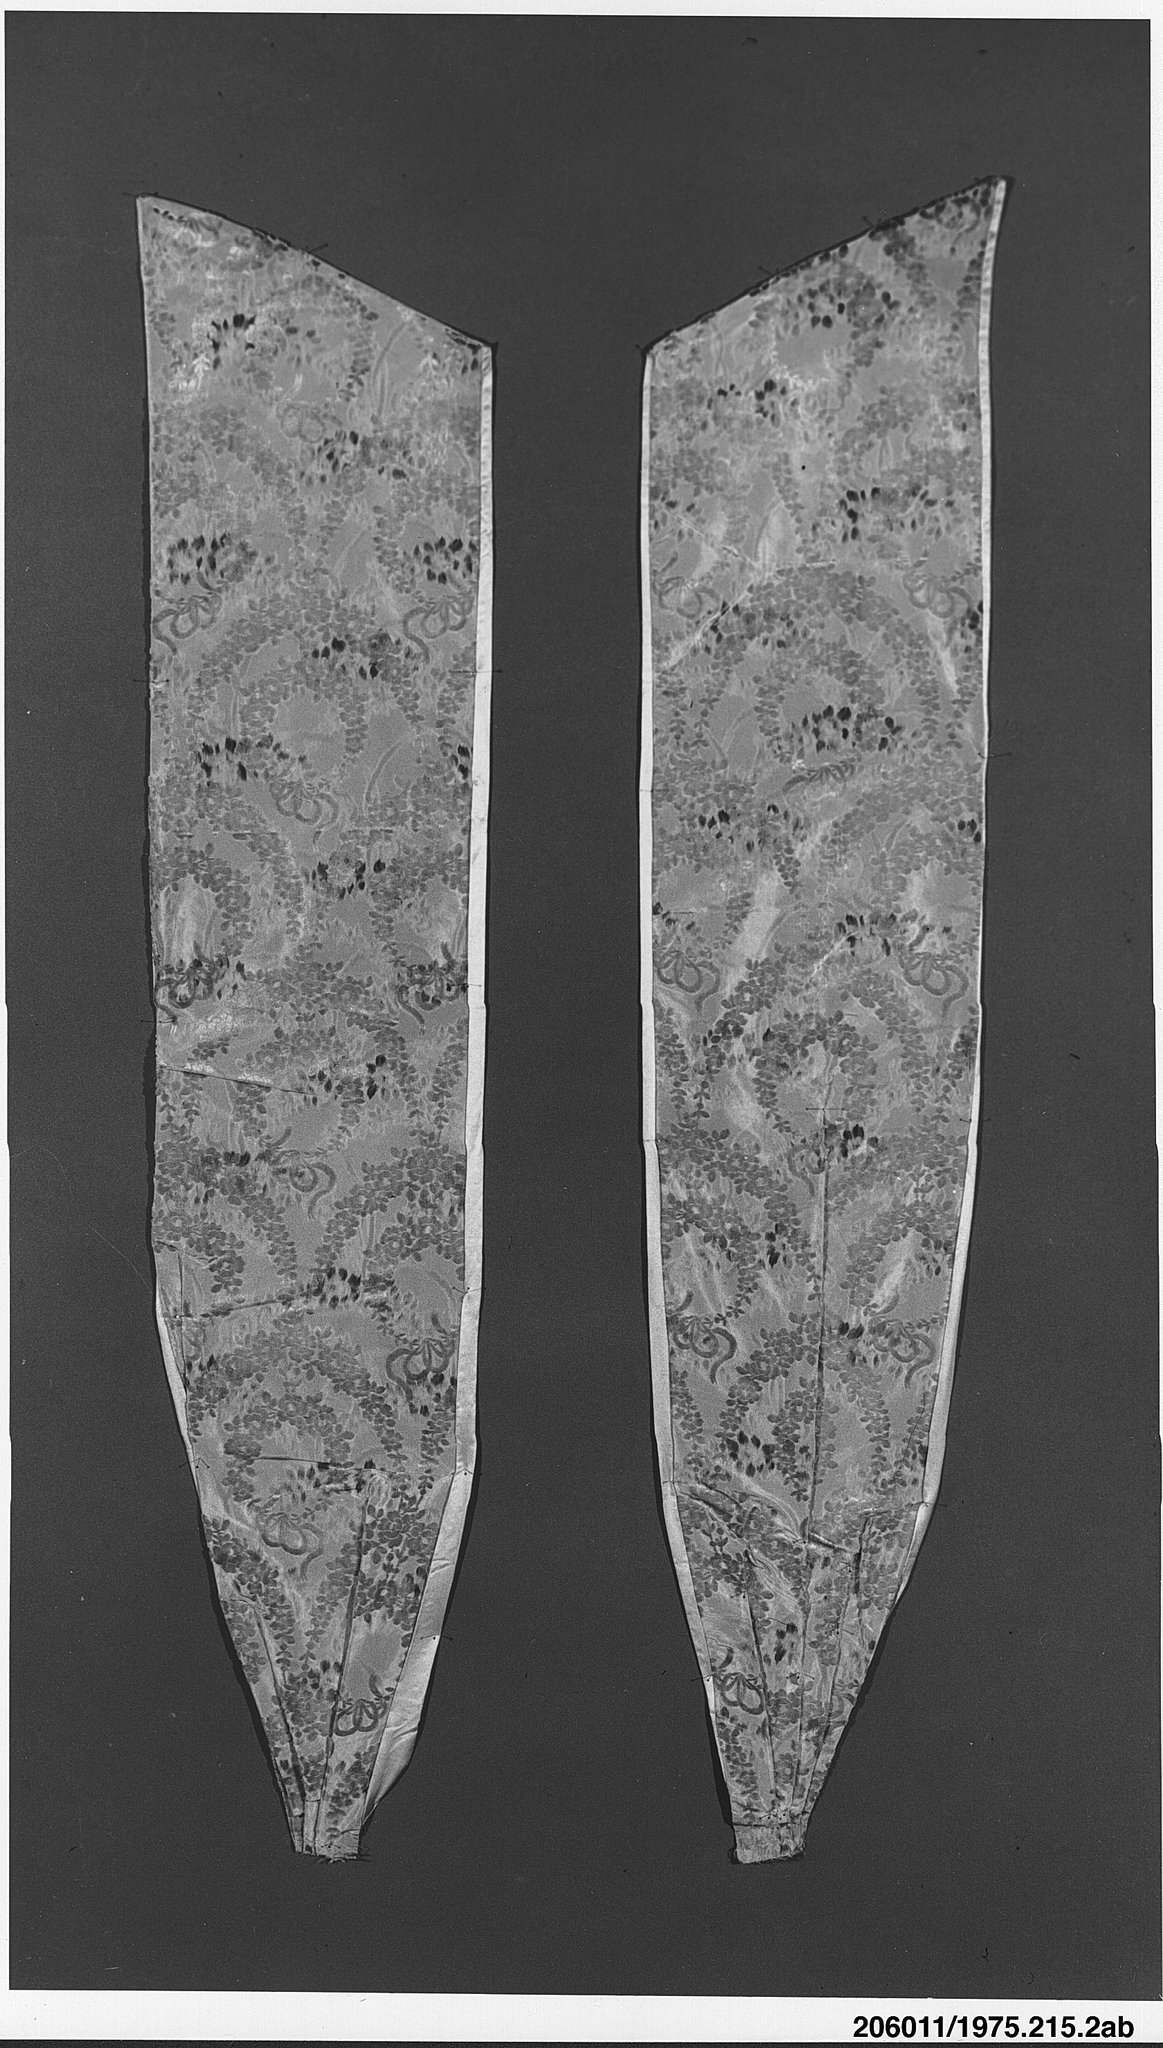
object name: sash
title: Pair of sashes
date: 1890-1899